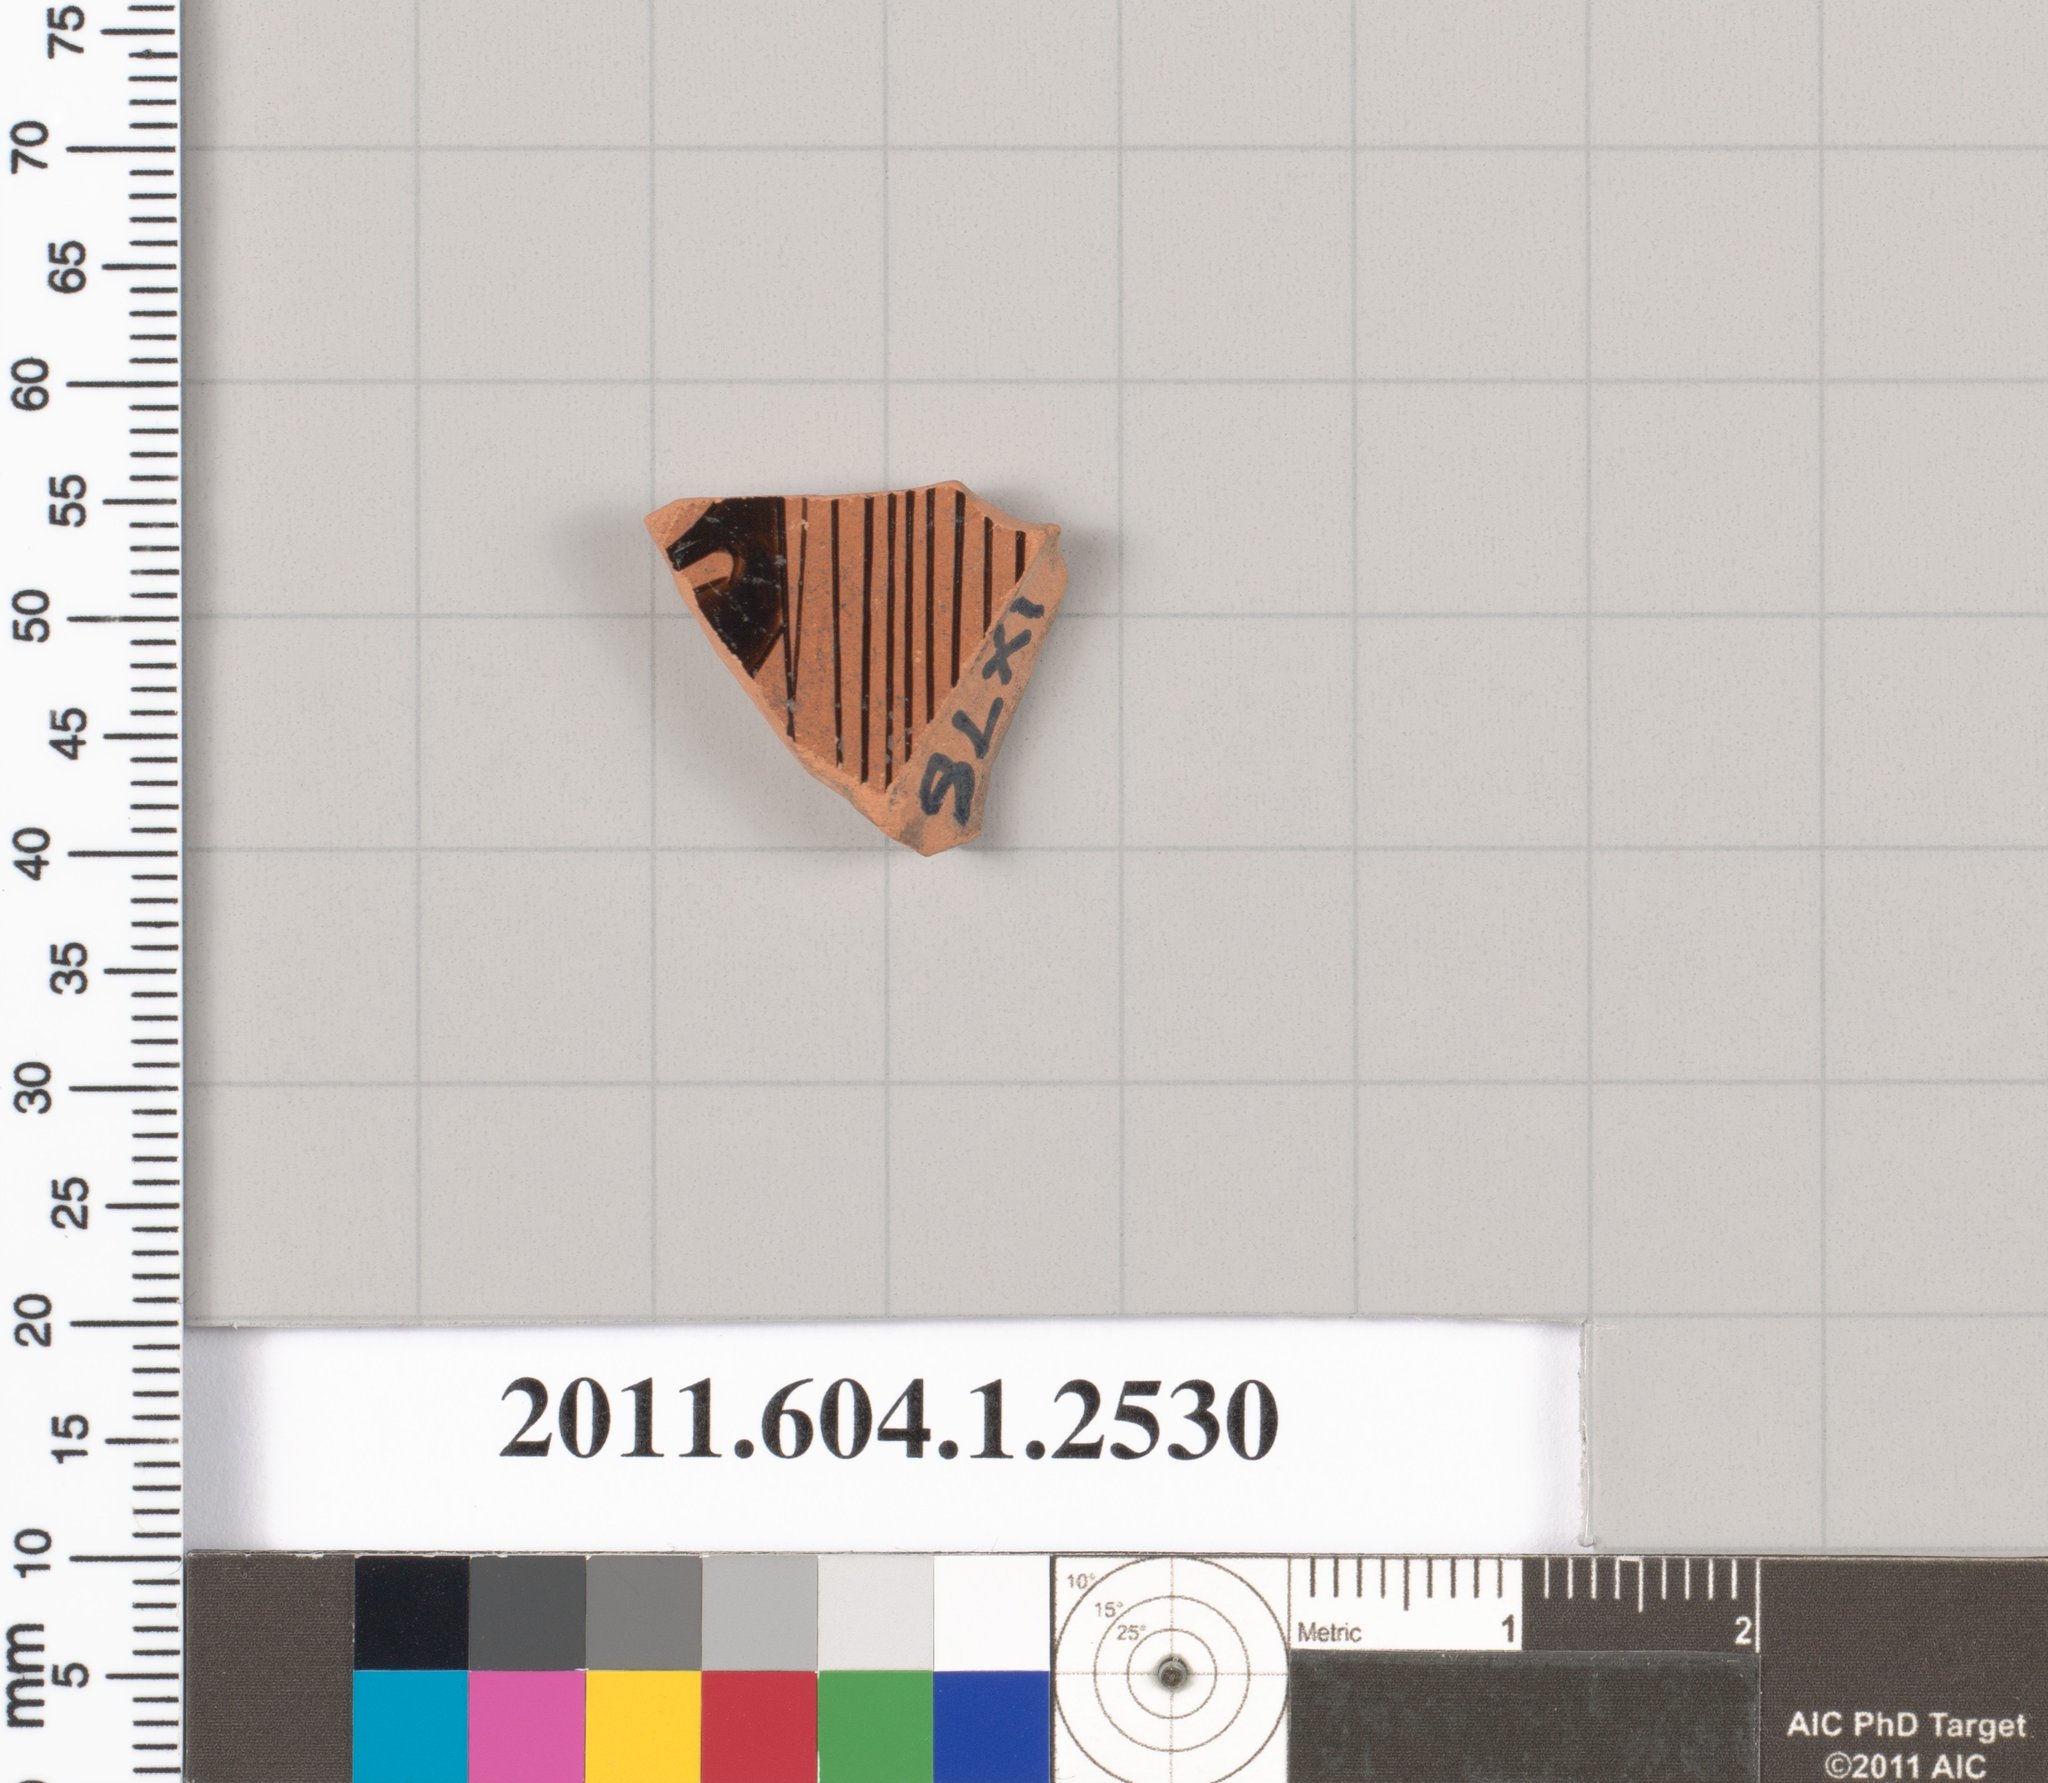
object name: kylix fragment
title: Terracotta fragment of a kylix (drinking cup)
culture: greek, attic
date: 490-480 BCE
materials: terracotta